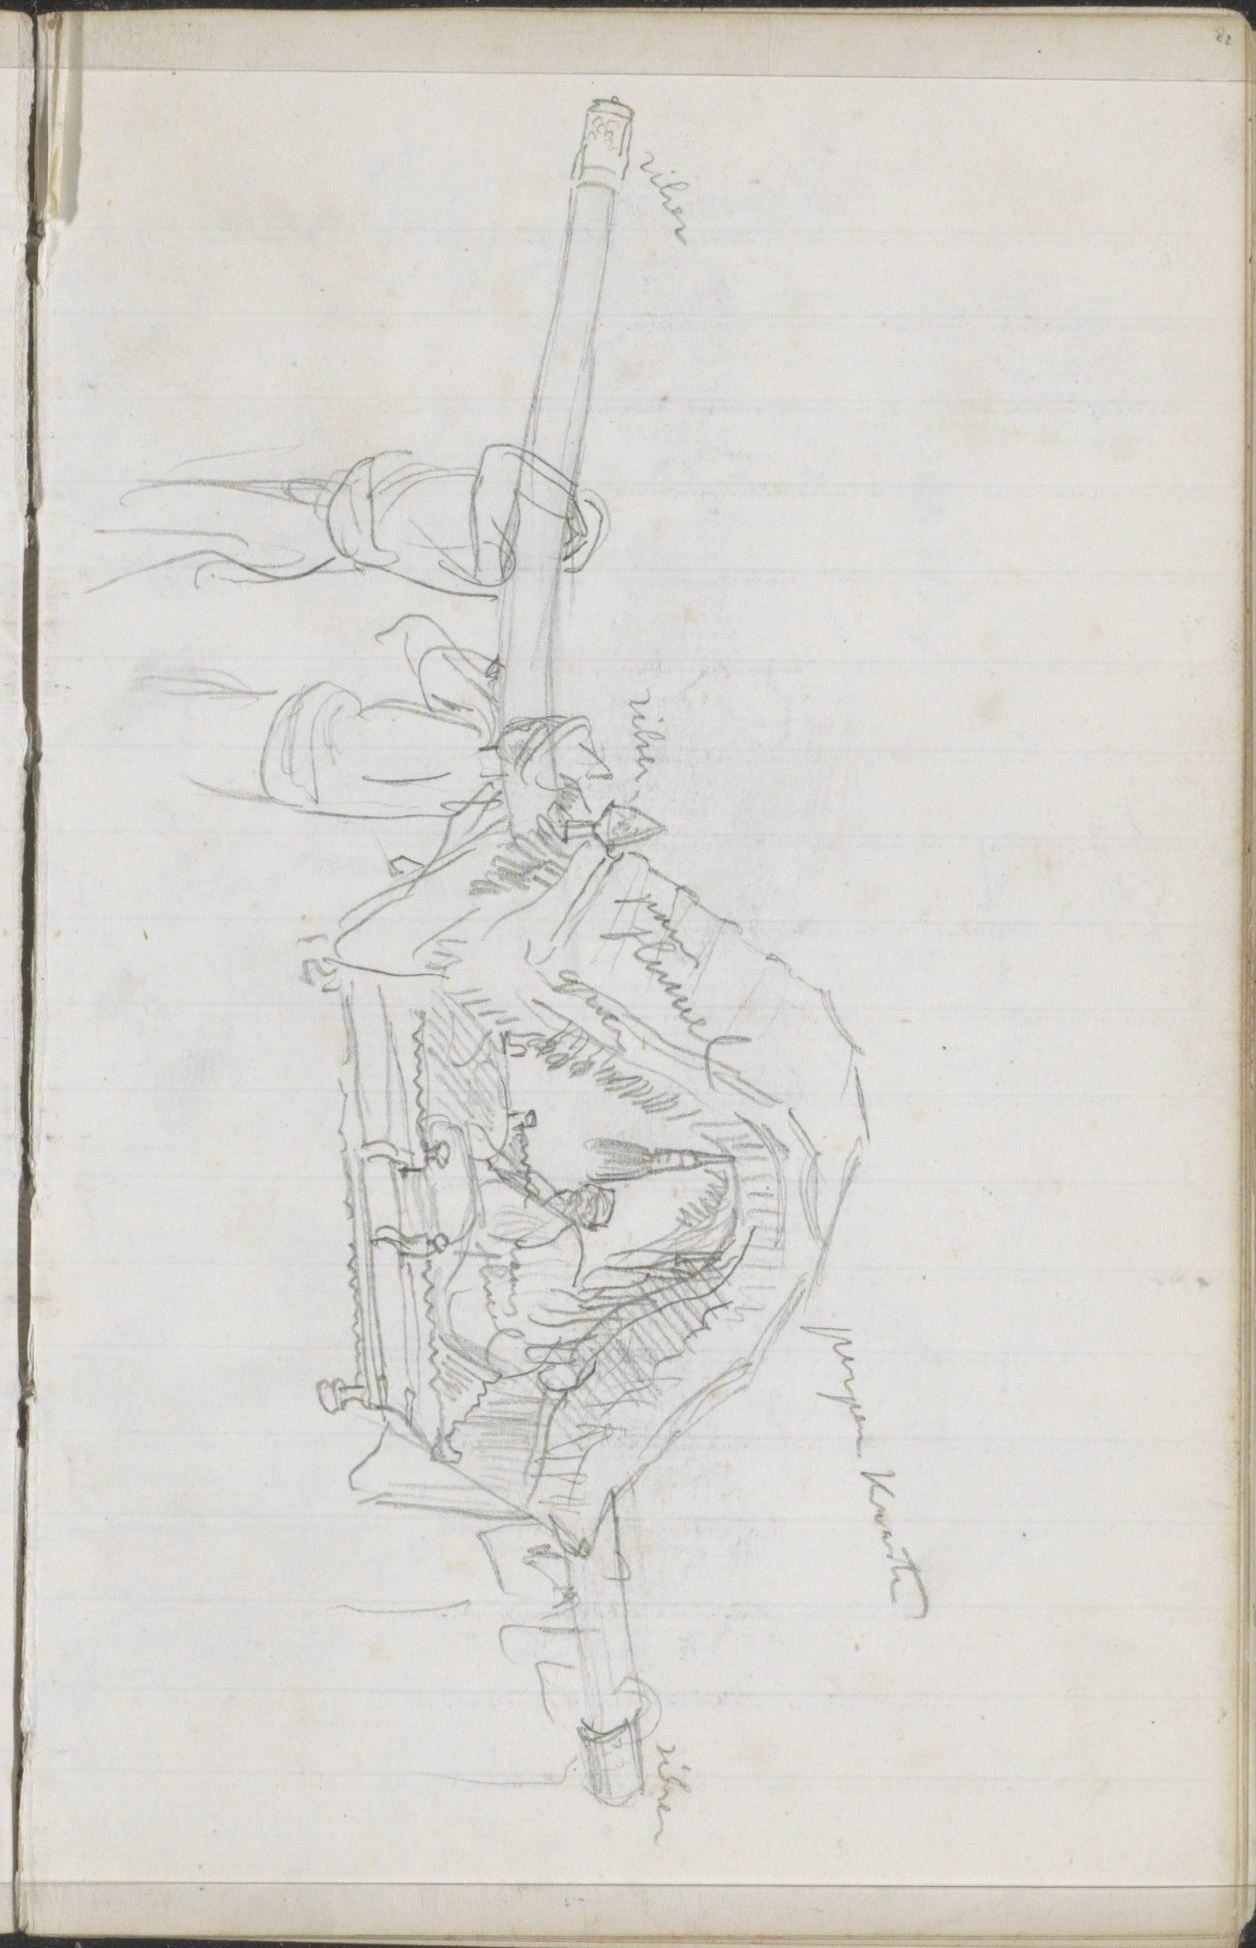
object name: sketchbook leaf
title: Indiase draagstoel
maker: marius bauer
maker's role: draughtsman, print maker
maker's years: 1867-1932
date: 1897-1898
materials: pencil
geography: india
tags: (carrying a person in a) sedan-chair, asiatic races and peoples: indians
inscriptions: kleurnotitie, handgeschreven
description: Twee mannen dragen de stoel, waarin een figuur zit op kussens. Pagina 82 uit een schetsboek met 62 bladen.